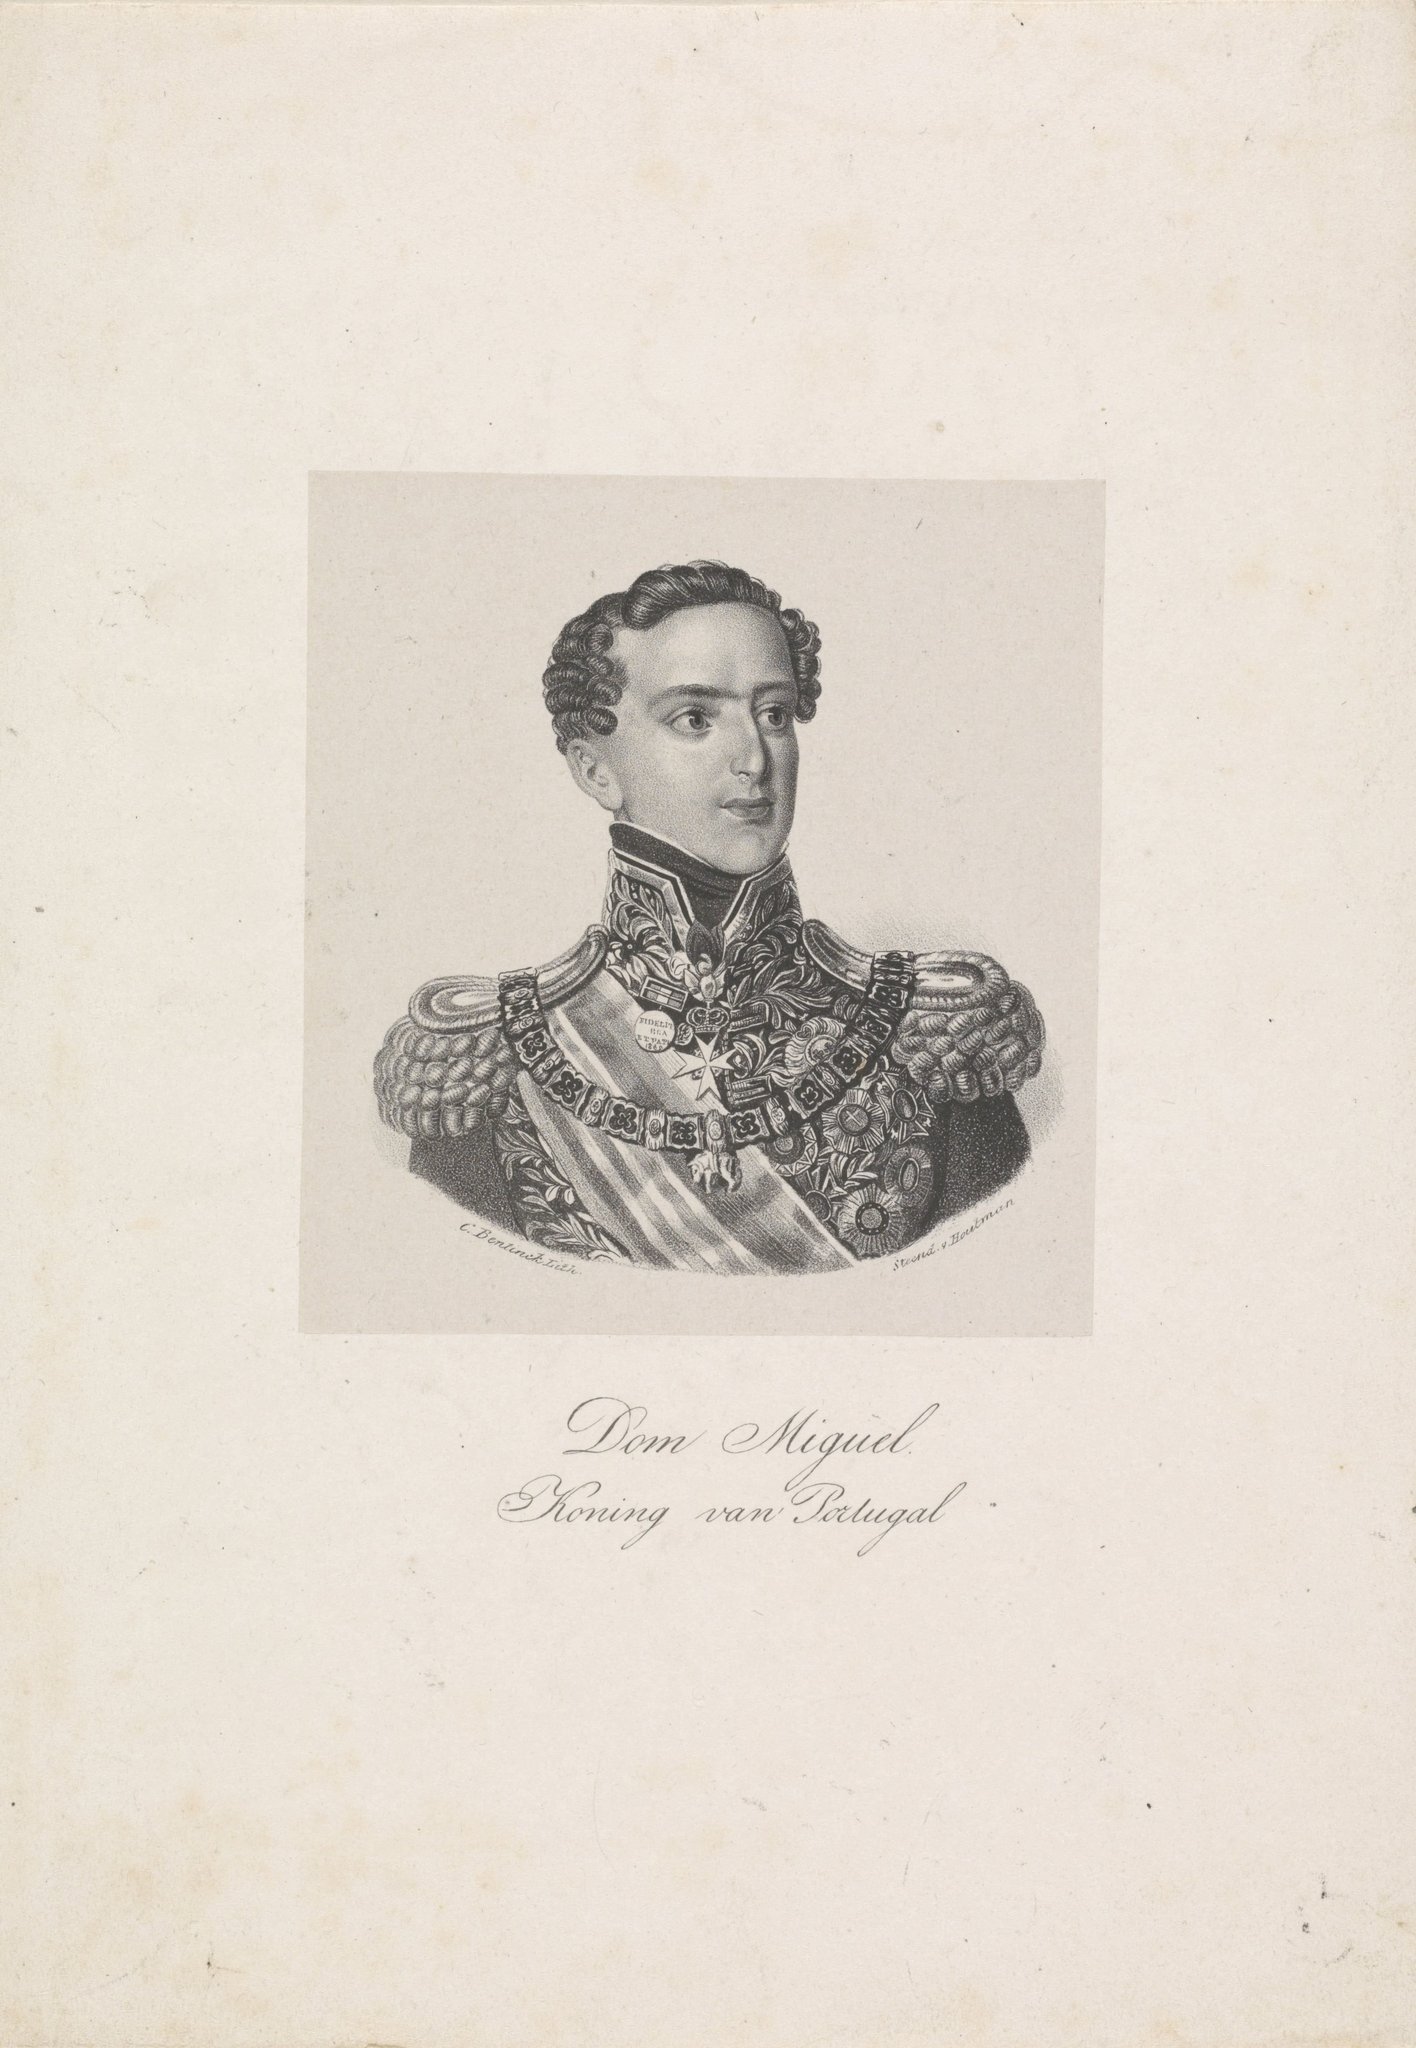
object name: print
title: Portret van Don Miguel, koning van Portugal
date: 1824-1849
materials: paper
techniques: lithograph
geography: netherlands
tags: knighthood order, historical persons, knighthood order of the golden fleece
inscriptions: collector's mark: Lugt 2228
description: De geportretteerde draagt een gedecoreerd uniform met epauletten. Aan een ketting hangt het symbool voor de orde van het gulden vlies.